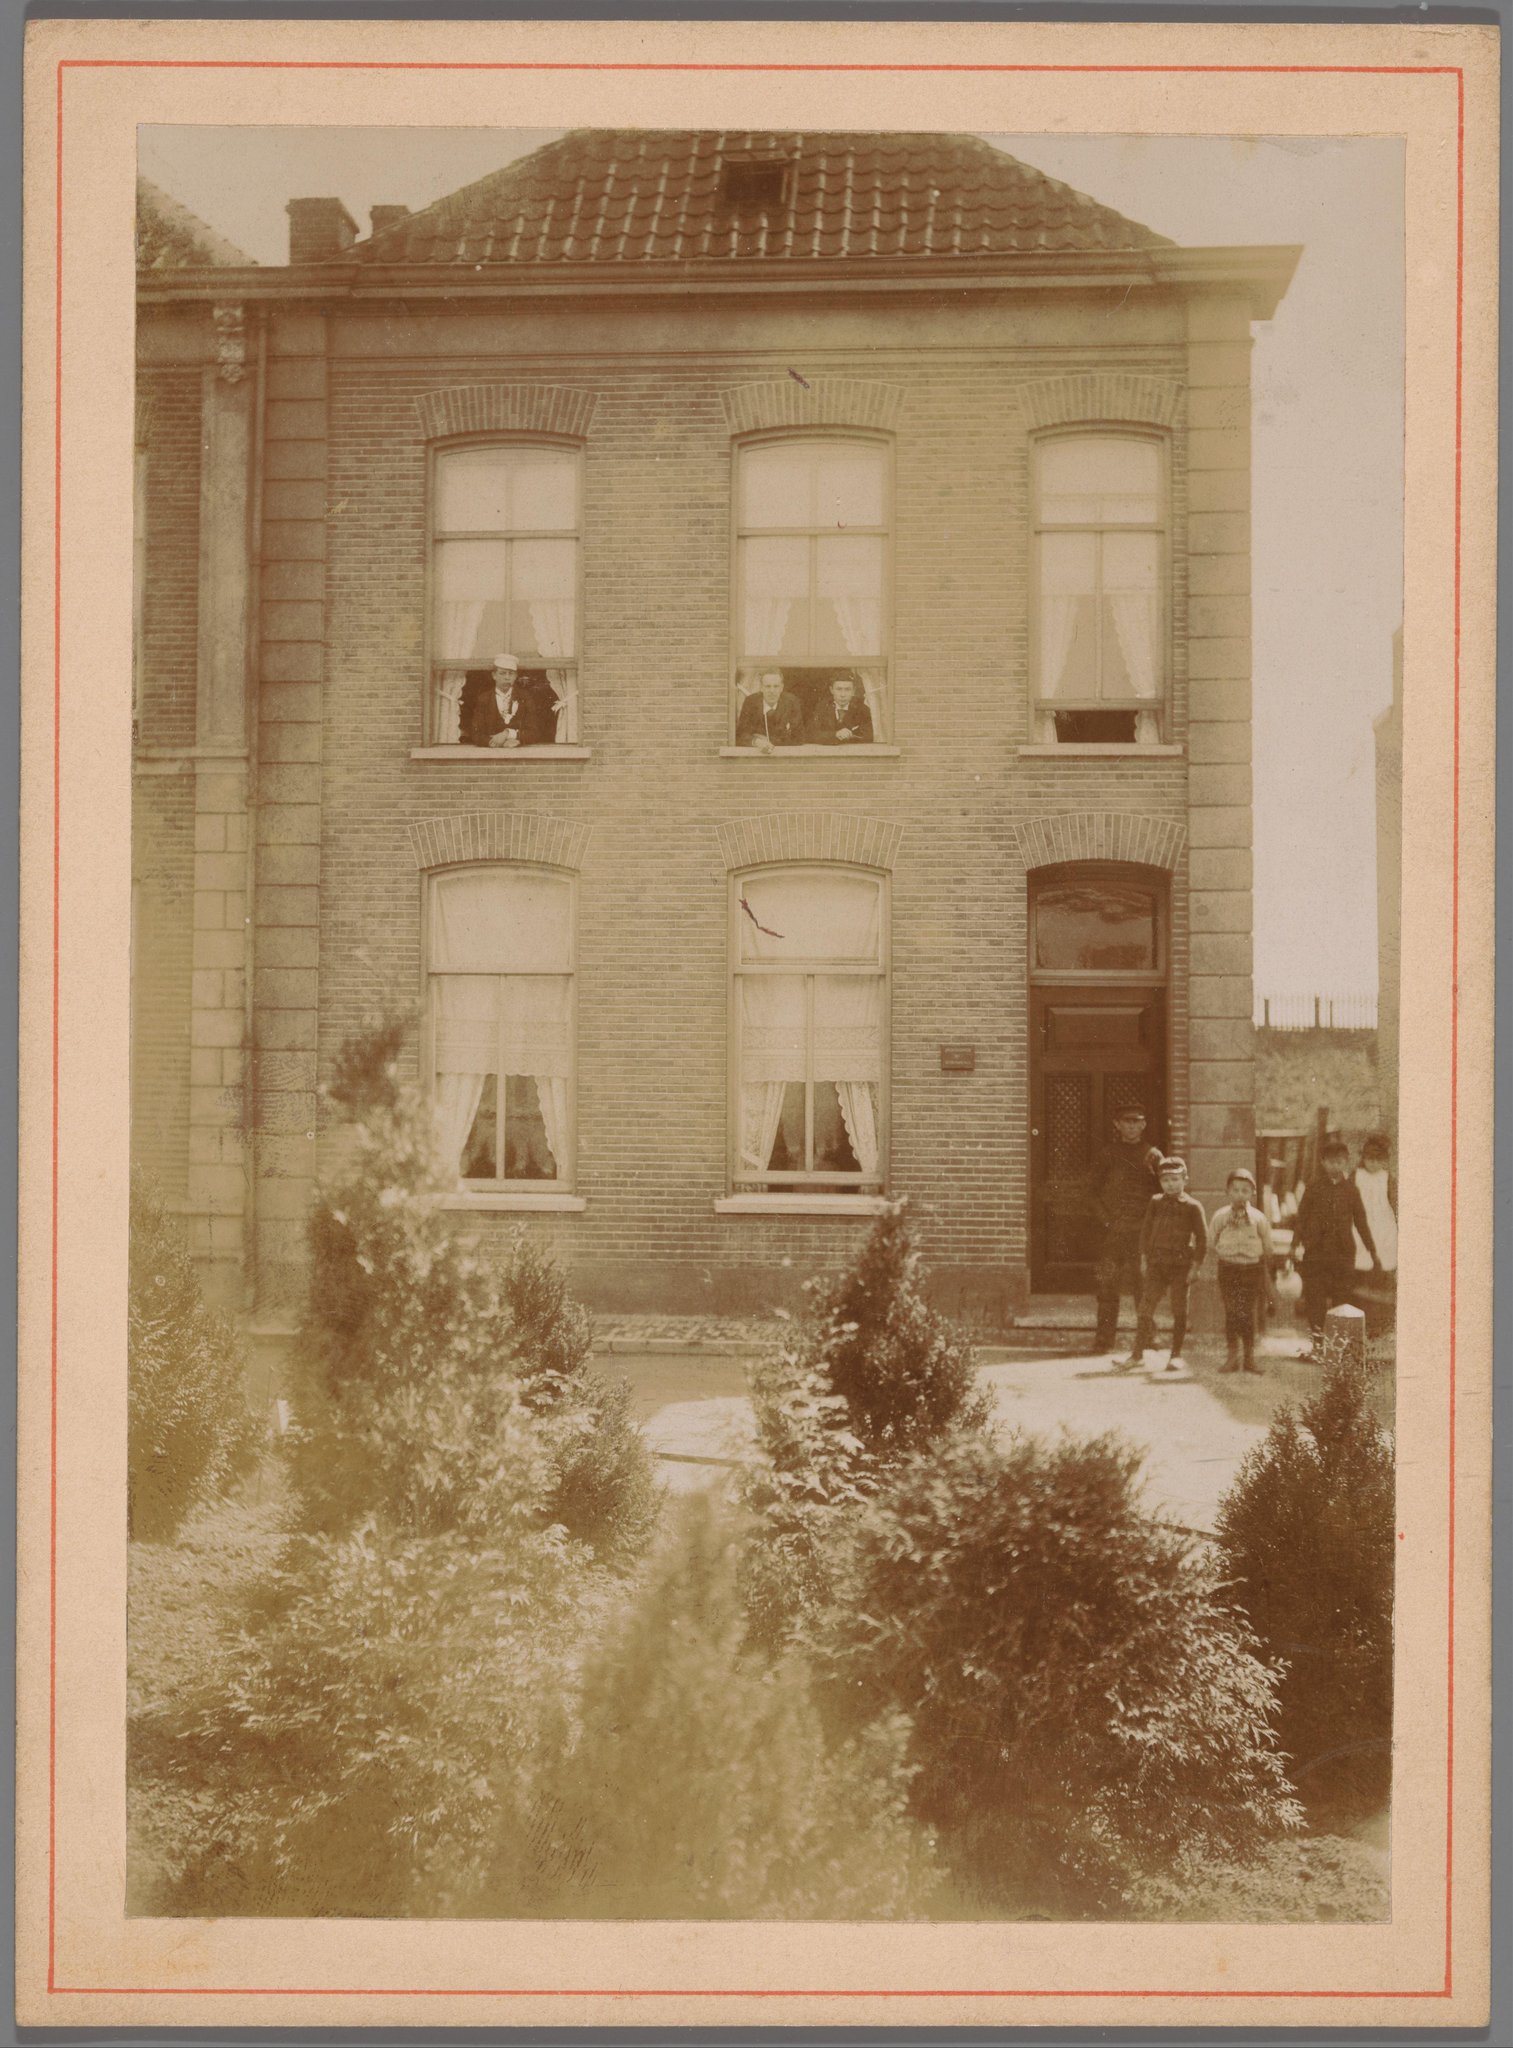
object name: photograph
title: Woning in Wageningen met studenten, waaronder linksboven een student aangeduid als van Haeften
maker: Anonymous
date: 1892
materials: paper, cardboard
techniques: collodion silver print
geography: wageningen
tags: student life